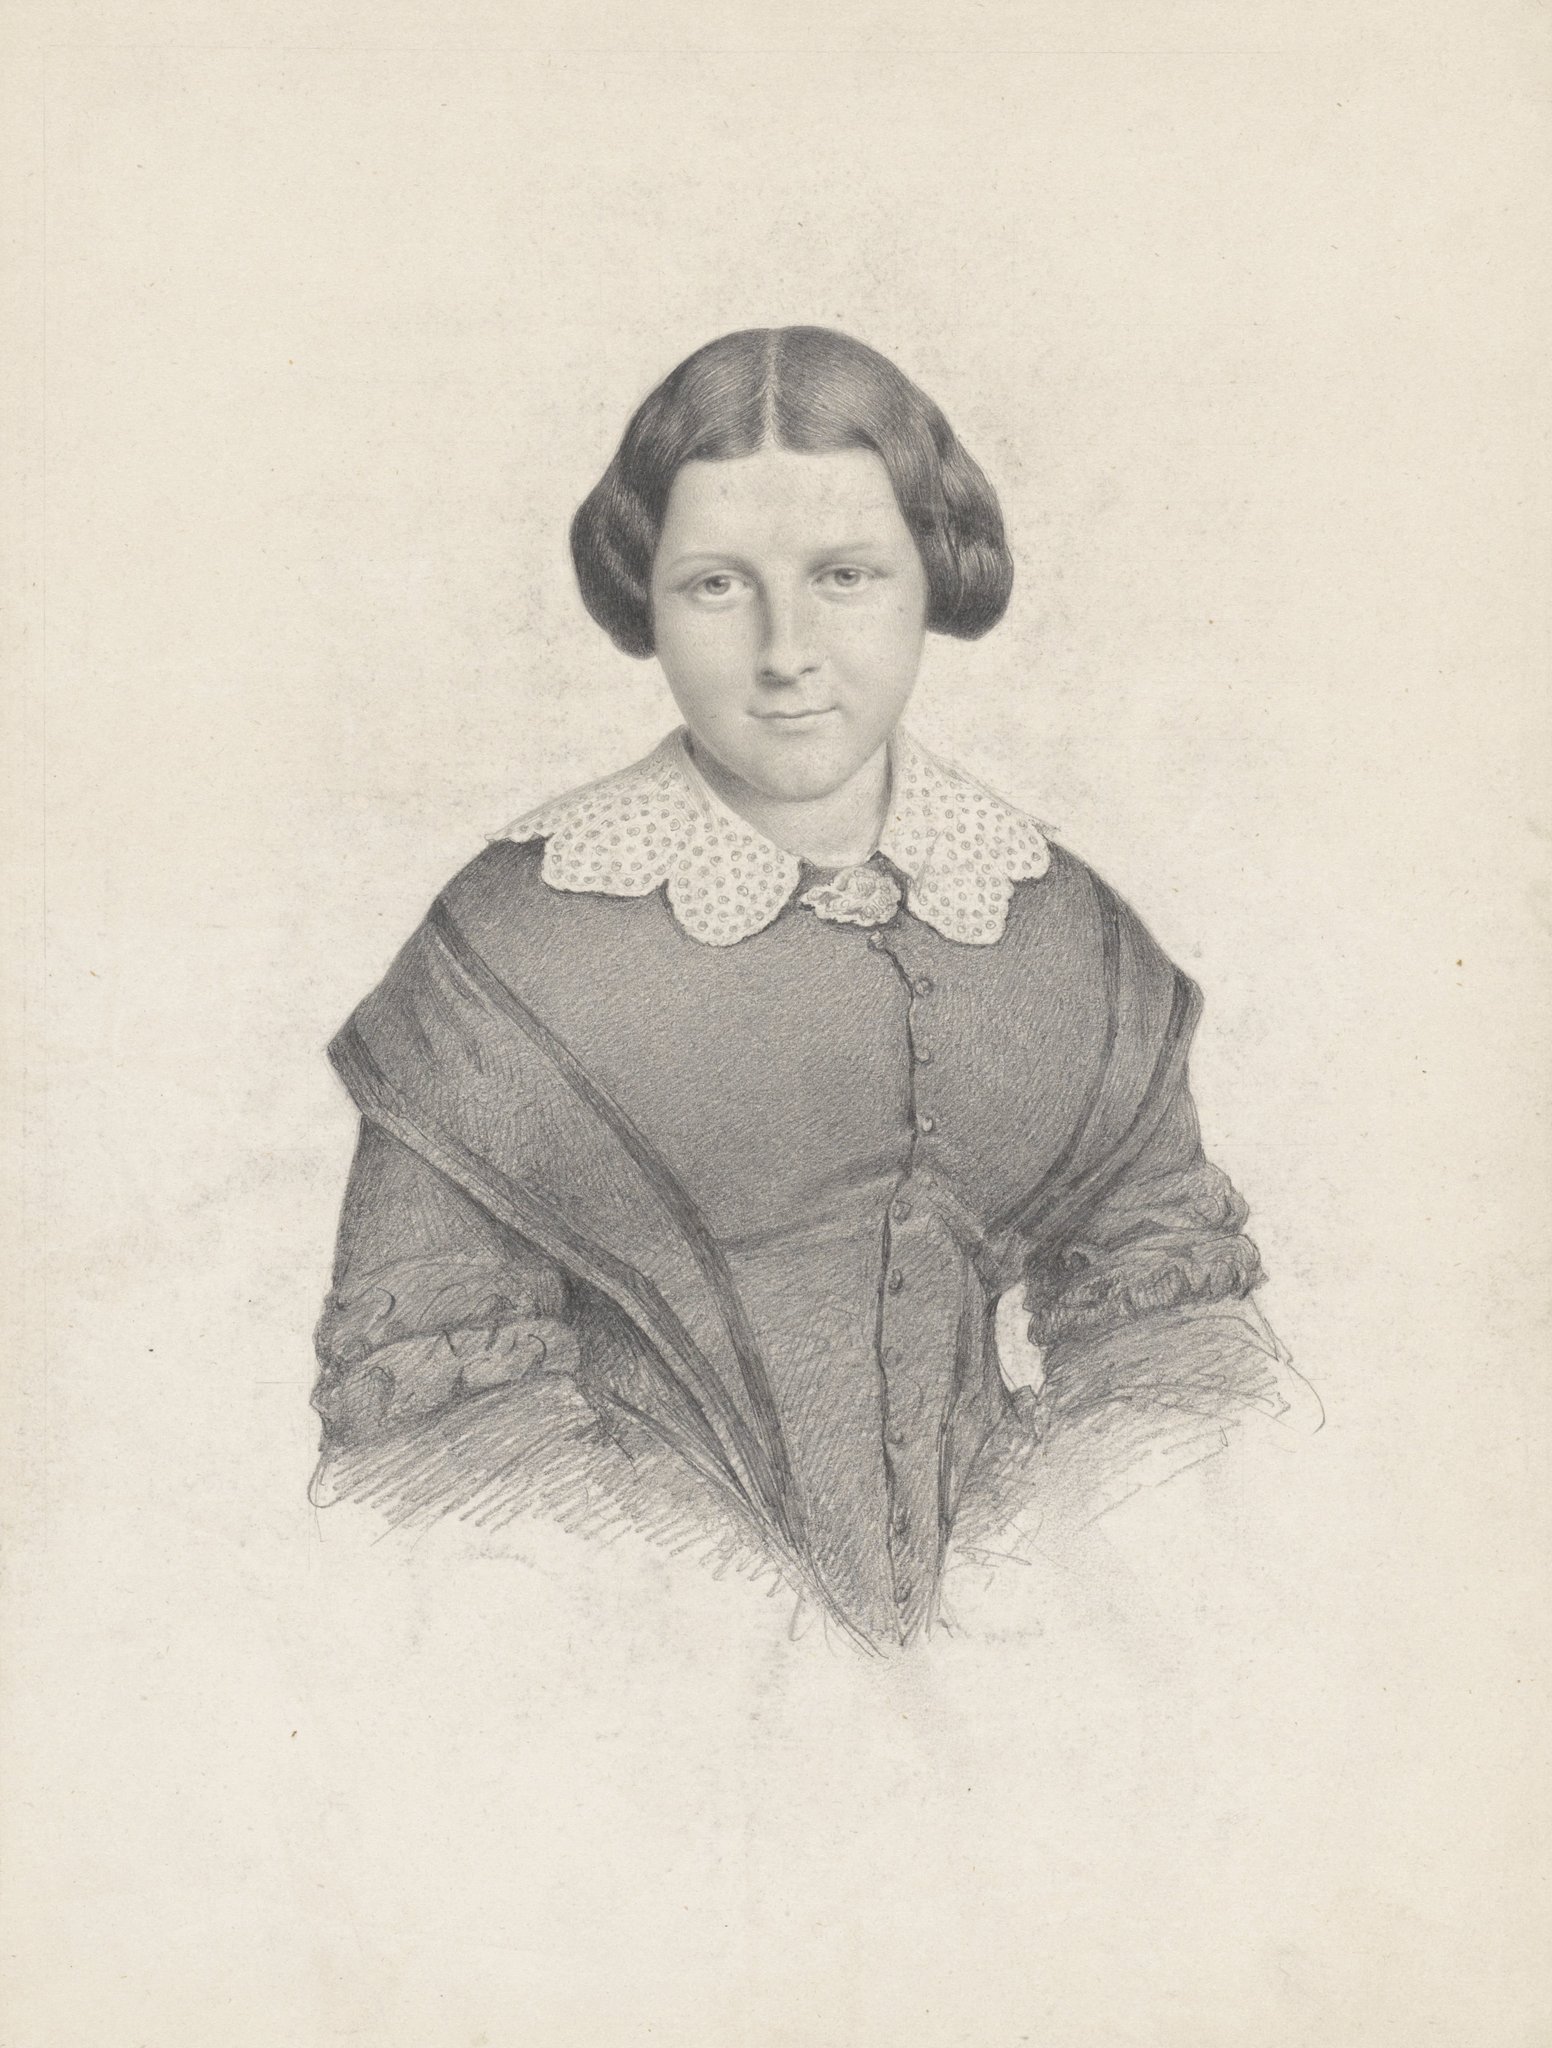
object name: drawing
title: Portret van een jonge vrouw, van voren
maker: jan cornelis van rossum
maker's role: draughtsman, painter, print maker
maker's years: 1820-1905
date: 1830-1903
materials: paper, pencil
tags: anonymous historical person portrayed alone